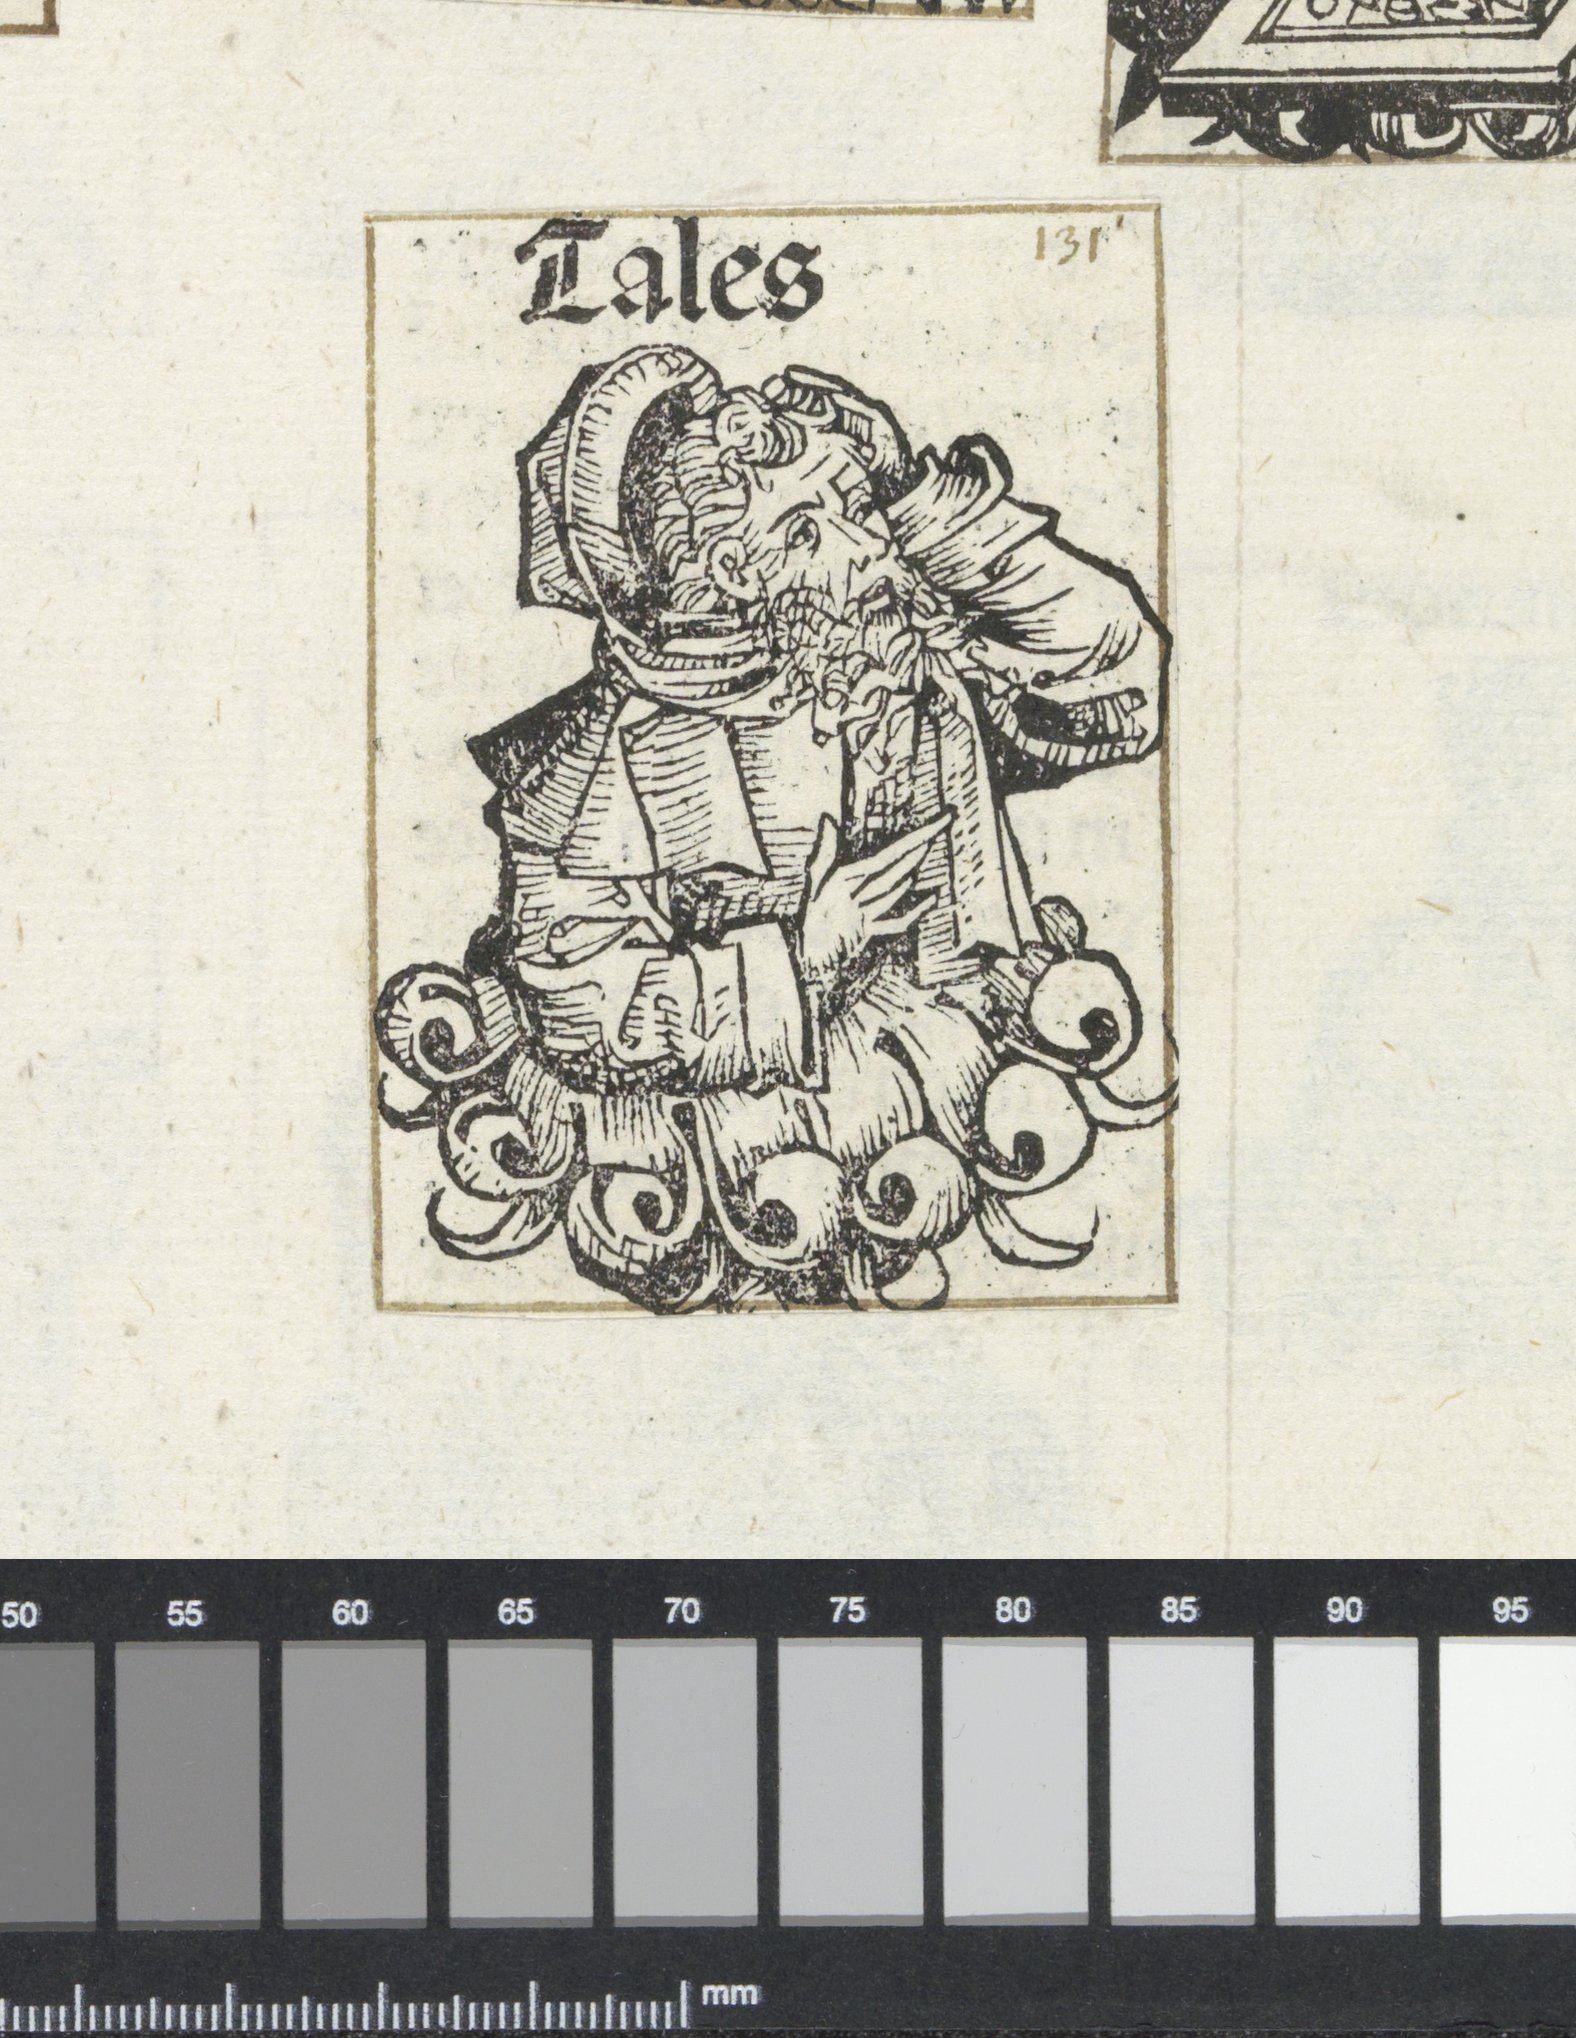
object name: book illustration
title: Liber Chronicarum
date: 1493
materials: paper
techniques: letterpress printing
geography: nuremberg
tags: the seven wise men of greece: bias, chilon, cleobulus, periander (alternatively myson), pittacus, solon, thales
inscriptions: inscription: ‘131’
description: Een bloemkelk met daarin een bebaarde man die zijn hand tegen zijn hoofd slaat. De tekst identificeert hem als Thales van Milete, één van de Zeven wijzen van Griekenland. De prent maakt deel uit van een album.